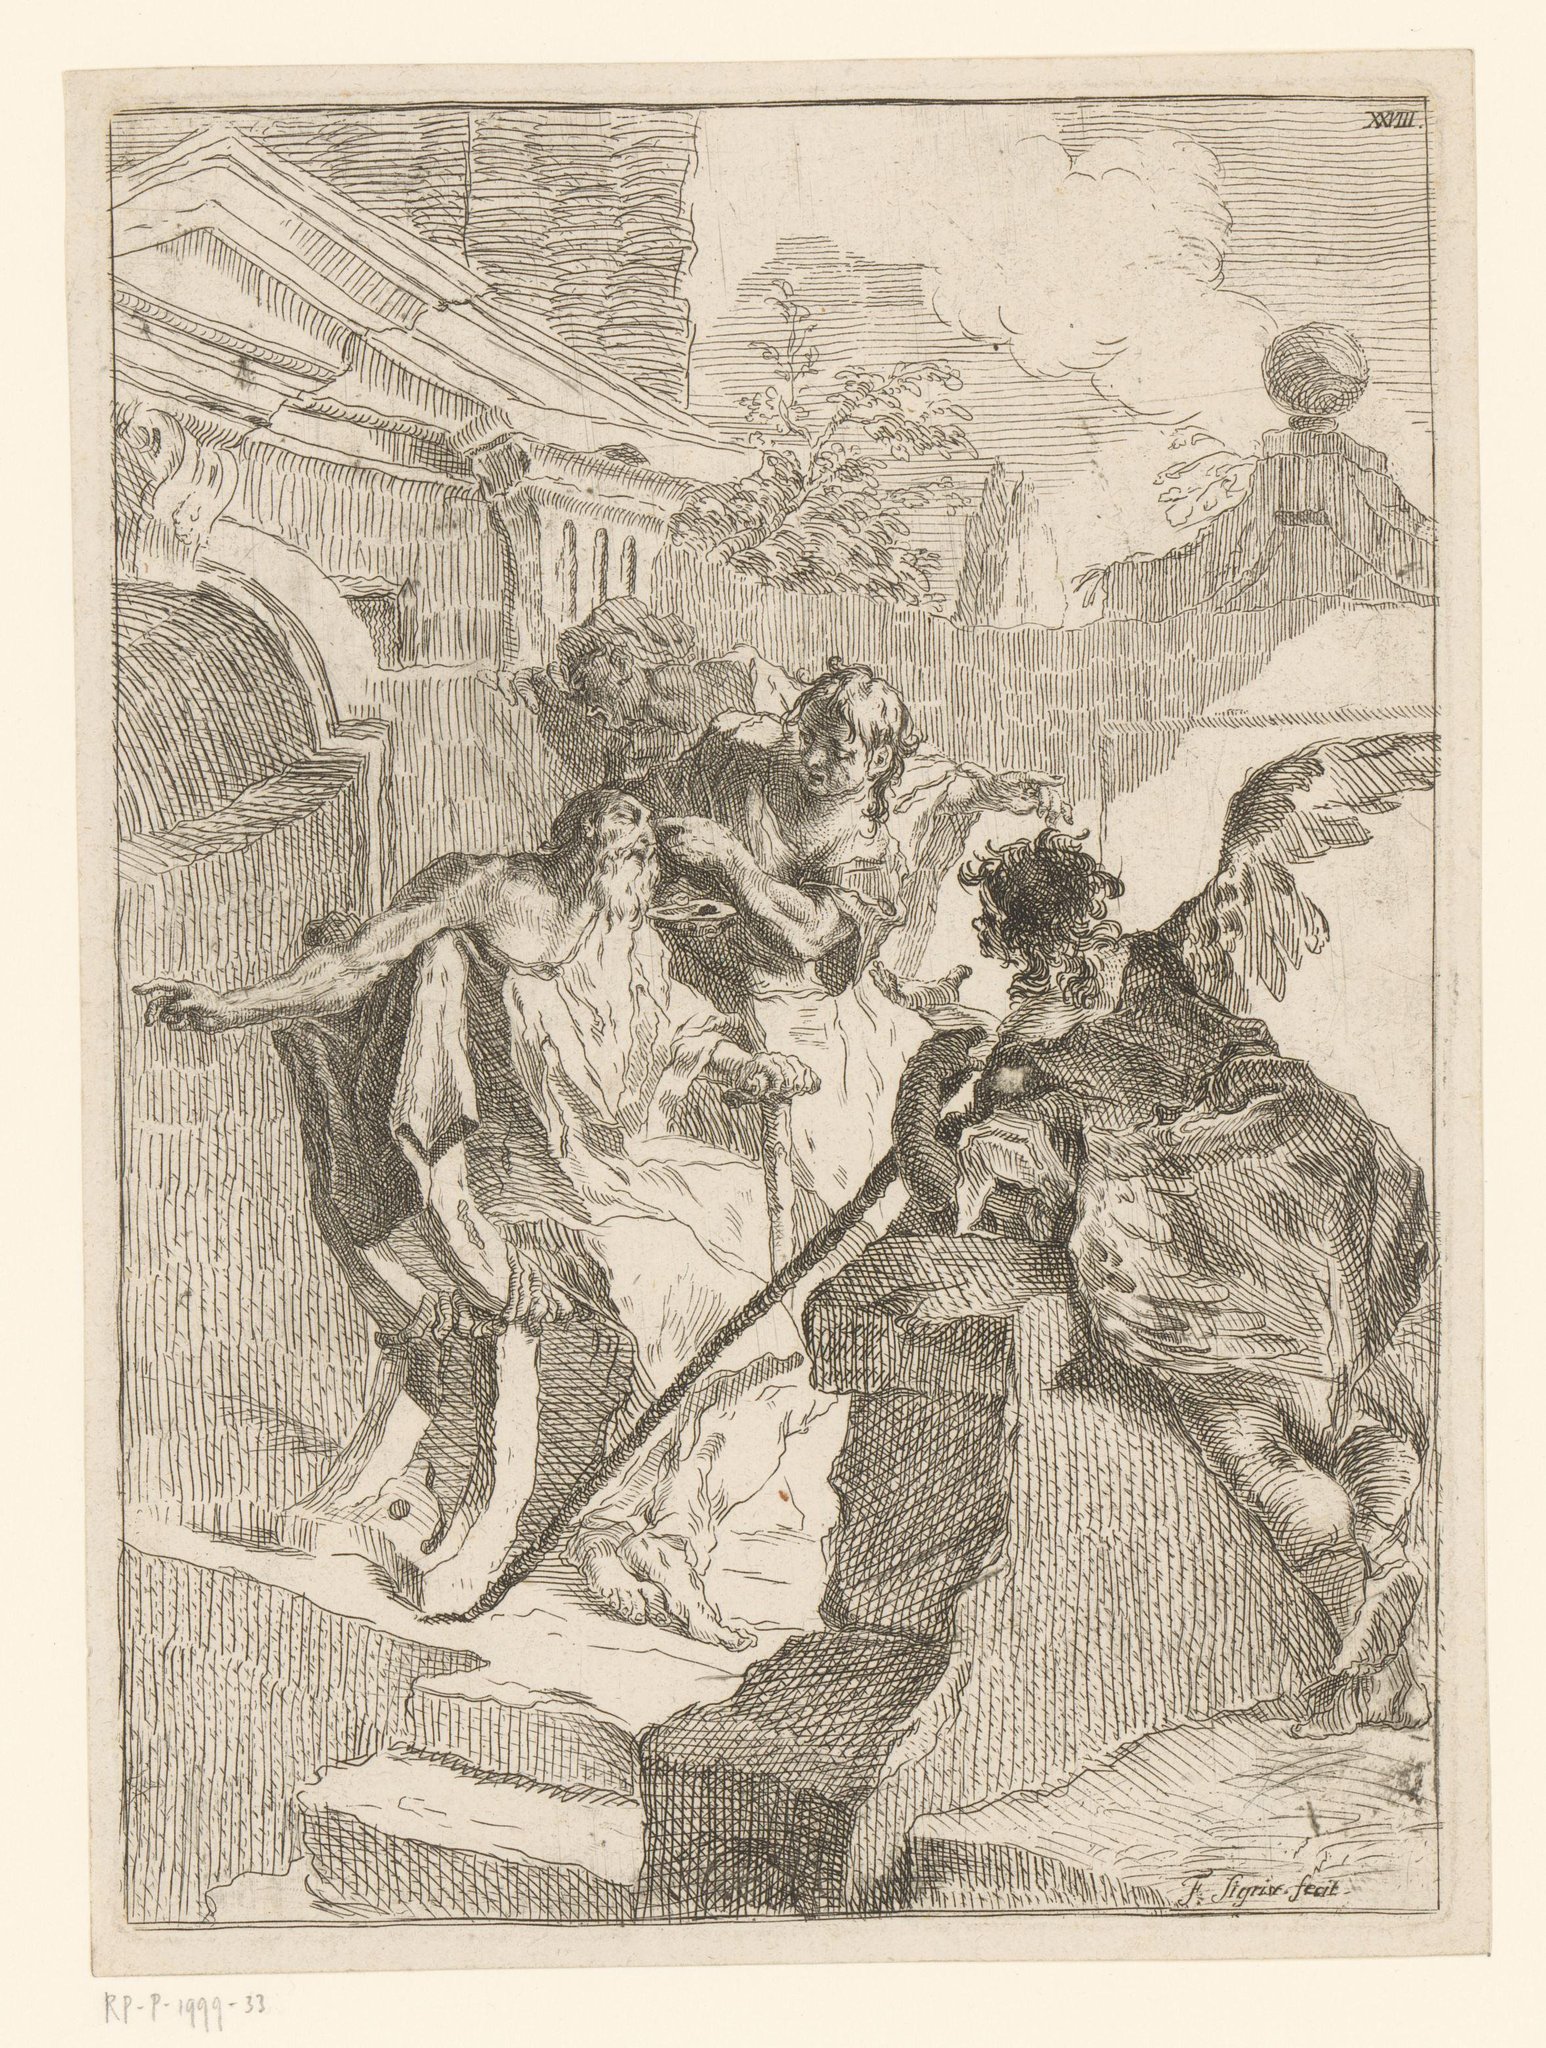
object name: print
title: Tobias geneest zijn blinde vader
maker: franz sigrist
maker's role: print maker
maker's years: 1727-1803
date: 1737-1803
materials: paper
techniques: etching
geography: germany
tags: the healing of tobit: tobias puts the gall of the fish on his father's eyes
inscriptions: collector's mark: Lugt 2228, collector's mark: Lugt 2760, collector's mark: Lugt 2827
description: Voor een antieke poort of ingang van een huis zit de blinde Tobias op een stoel. De jonge Tobias staat naast hem en smeert het geneesmiddel op zijn vaders ogen. Rechts op de voorgrond leunt de engel over een muurtje en kijkt toe. Rechtsboven gedrukt nummer XXVIII.